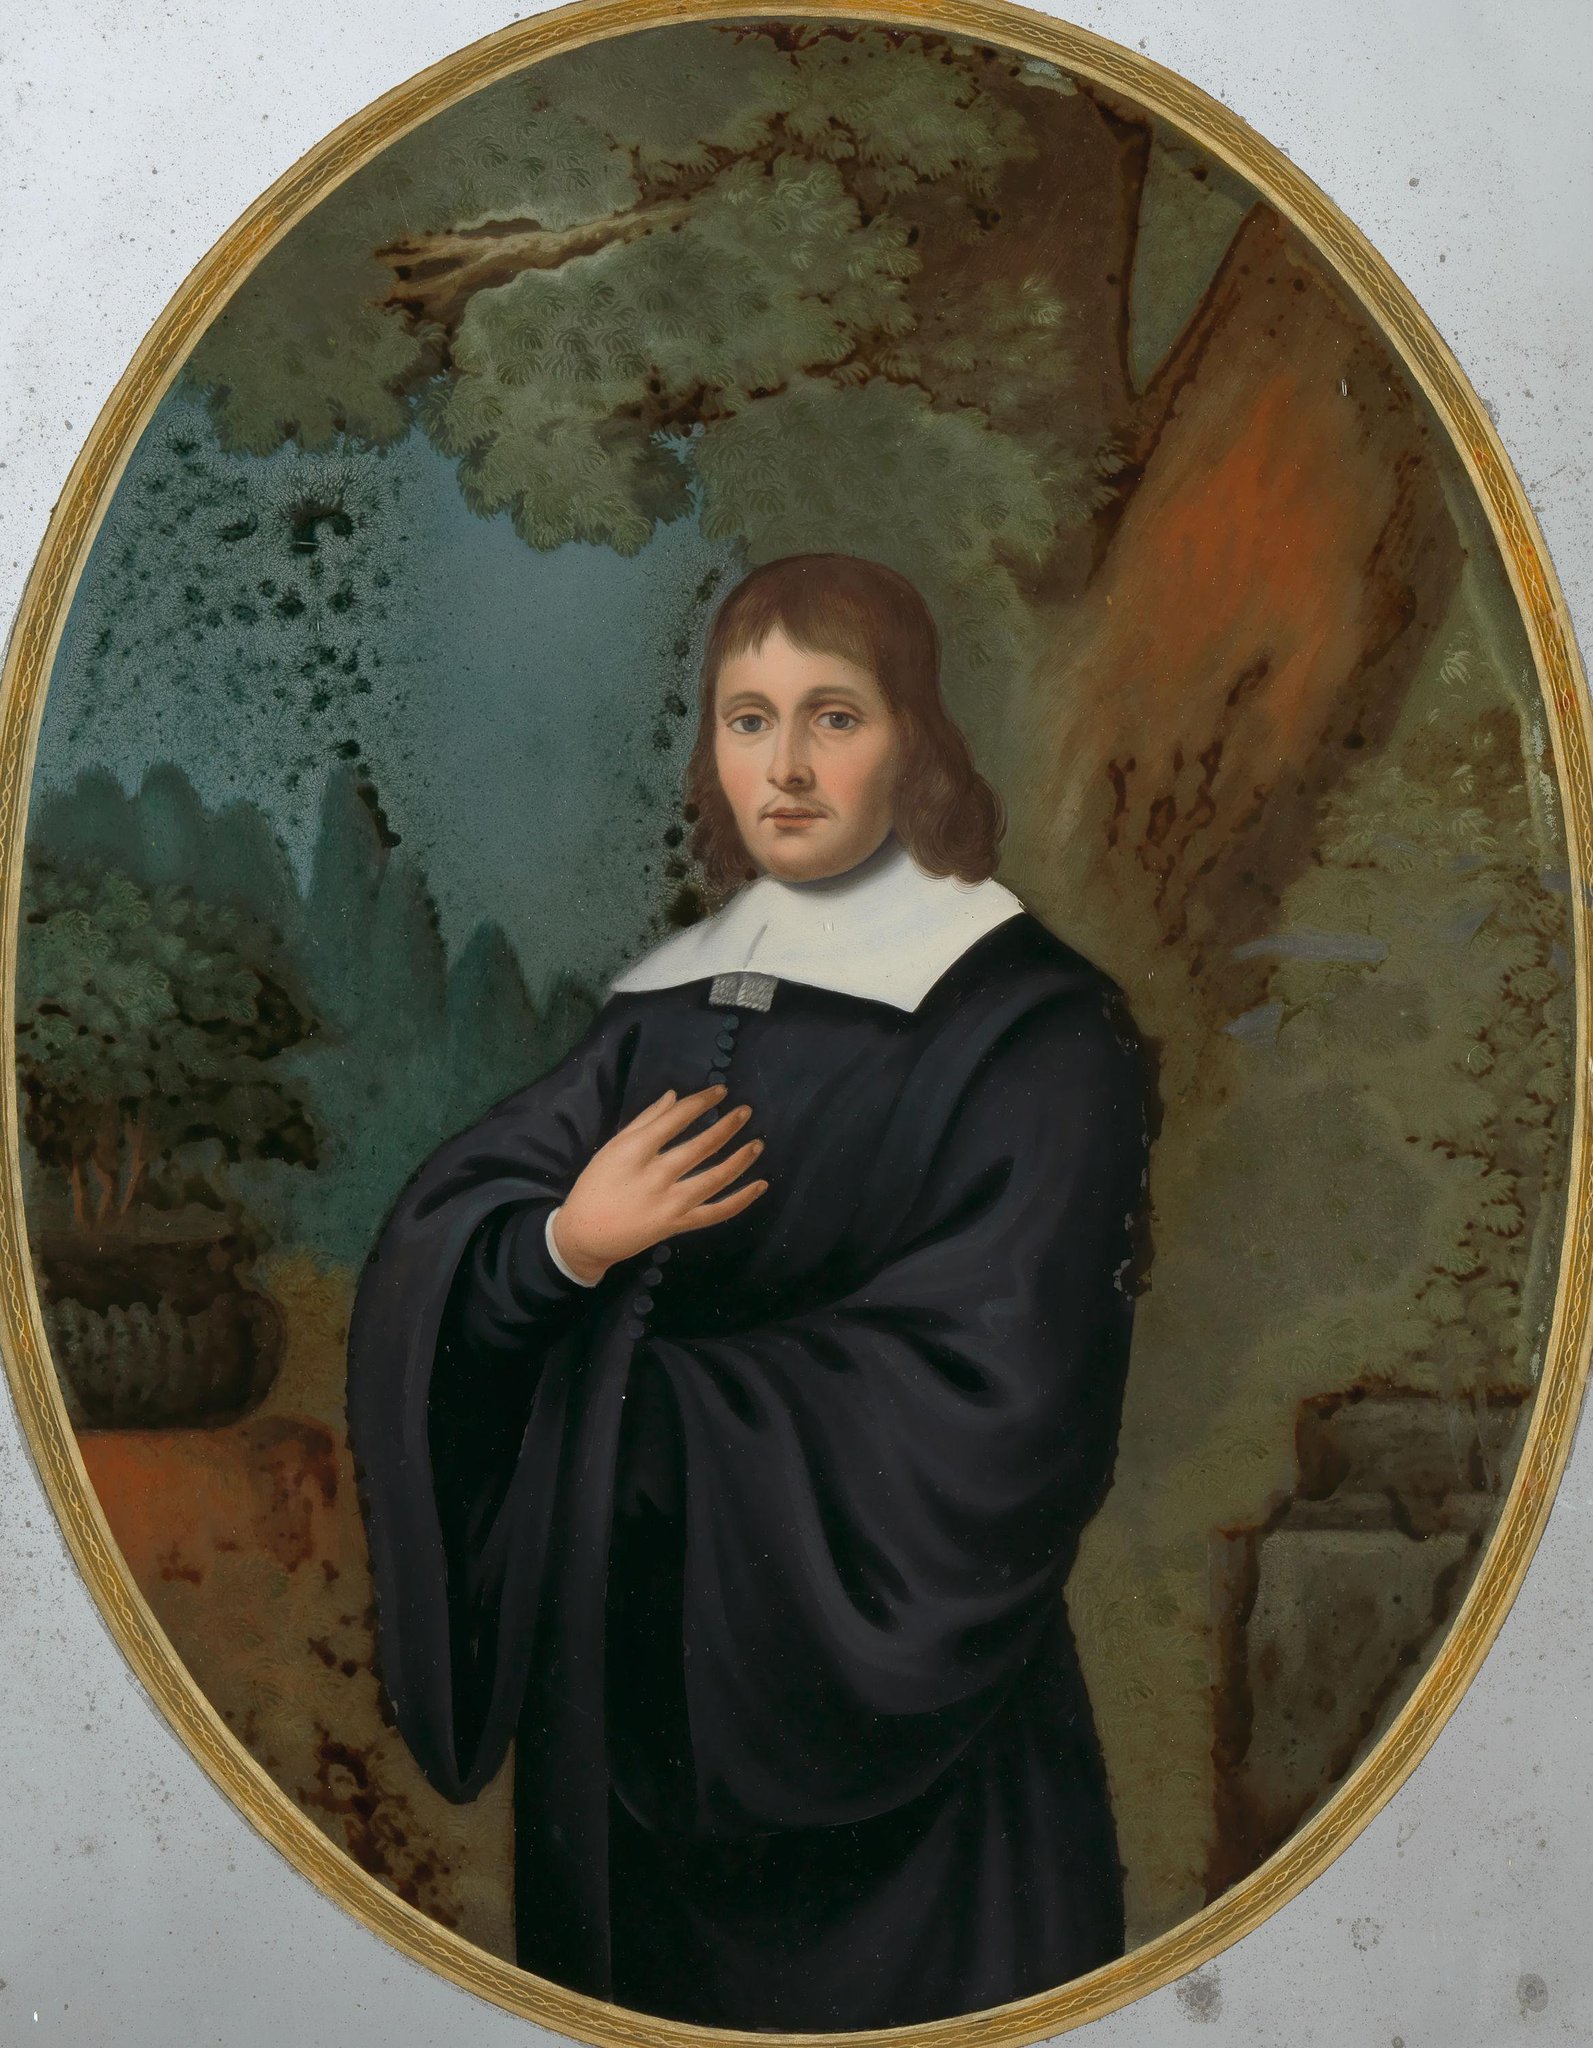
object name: reverse painting on glass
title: Portrait of a Man in 17th-century Clothing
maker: Anonymous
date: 1750-1799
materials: amalgam, glass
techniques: verre églomisé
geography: northern netherlands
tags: historical persons not known by name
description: Portret van een man in zeventiende-eeuwse kleding. Kniestuk in ovaal, staande voor geboomte.